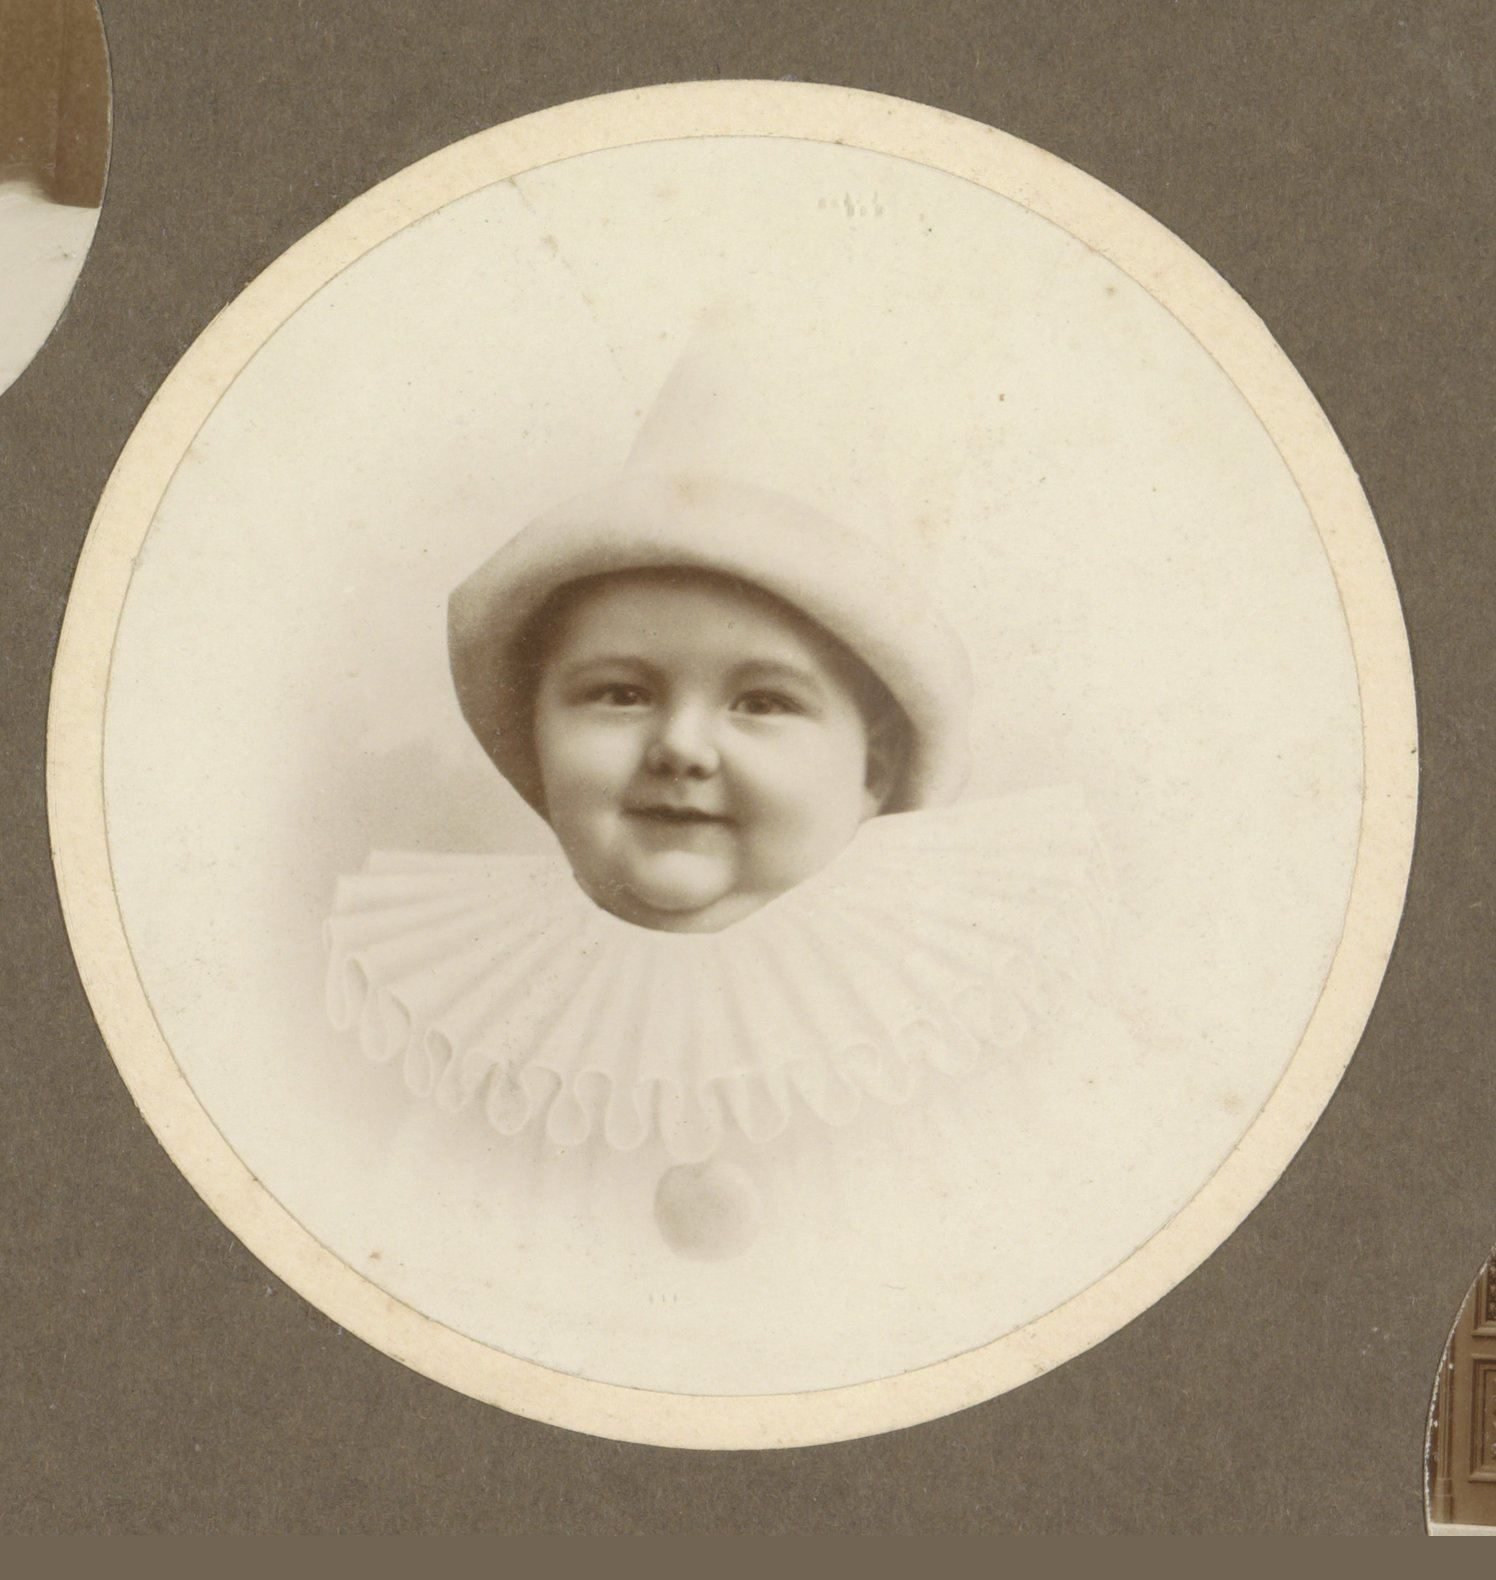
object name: photograph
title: Portret van een kleuter verkleed als pierrot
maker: cornelis johannes lodewicus vermeulen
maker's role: fotograaf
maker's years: 1861-1936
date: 1900-1920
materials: paper, photographic support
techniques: gelatin silver print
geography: the hague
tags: types in 'commedia dell'arte': pierrot, tot, toddler ~ the ages of man, the hague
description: Onderdeel van Fotoalbum met opnames van het gezin en het huis van fotograaf C.J.L. Vermeulen in Den Haag.